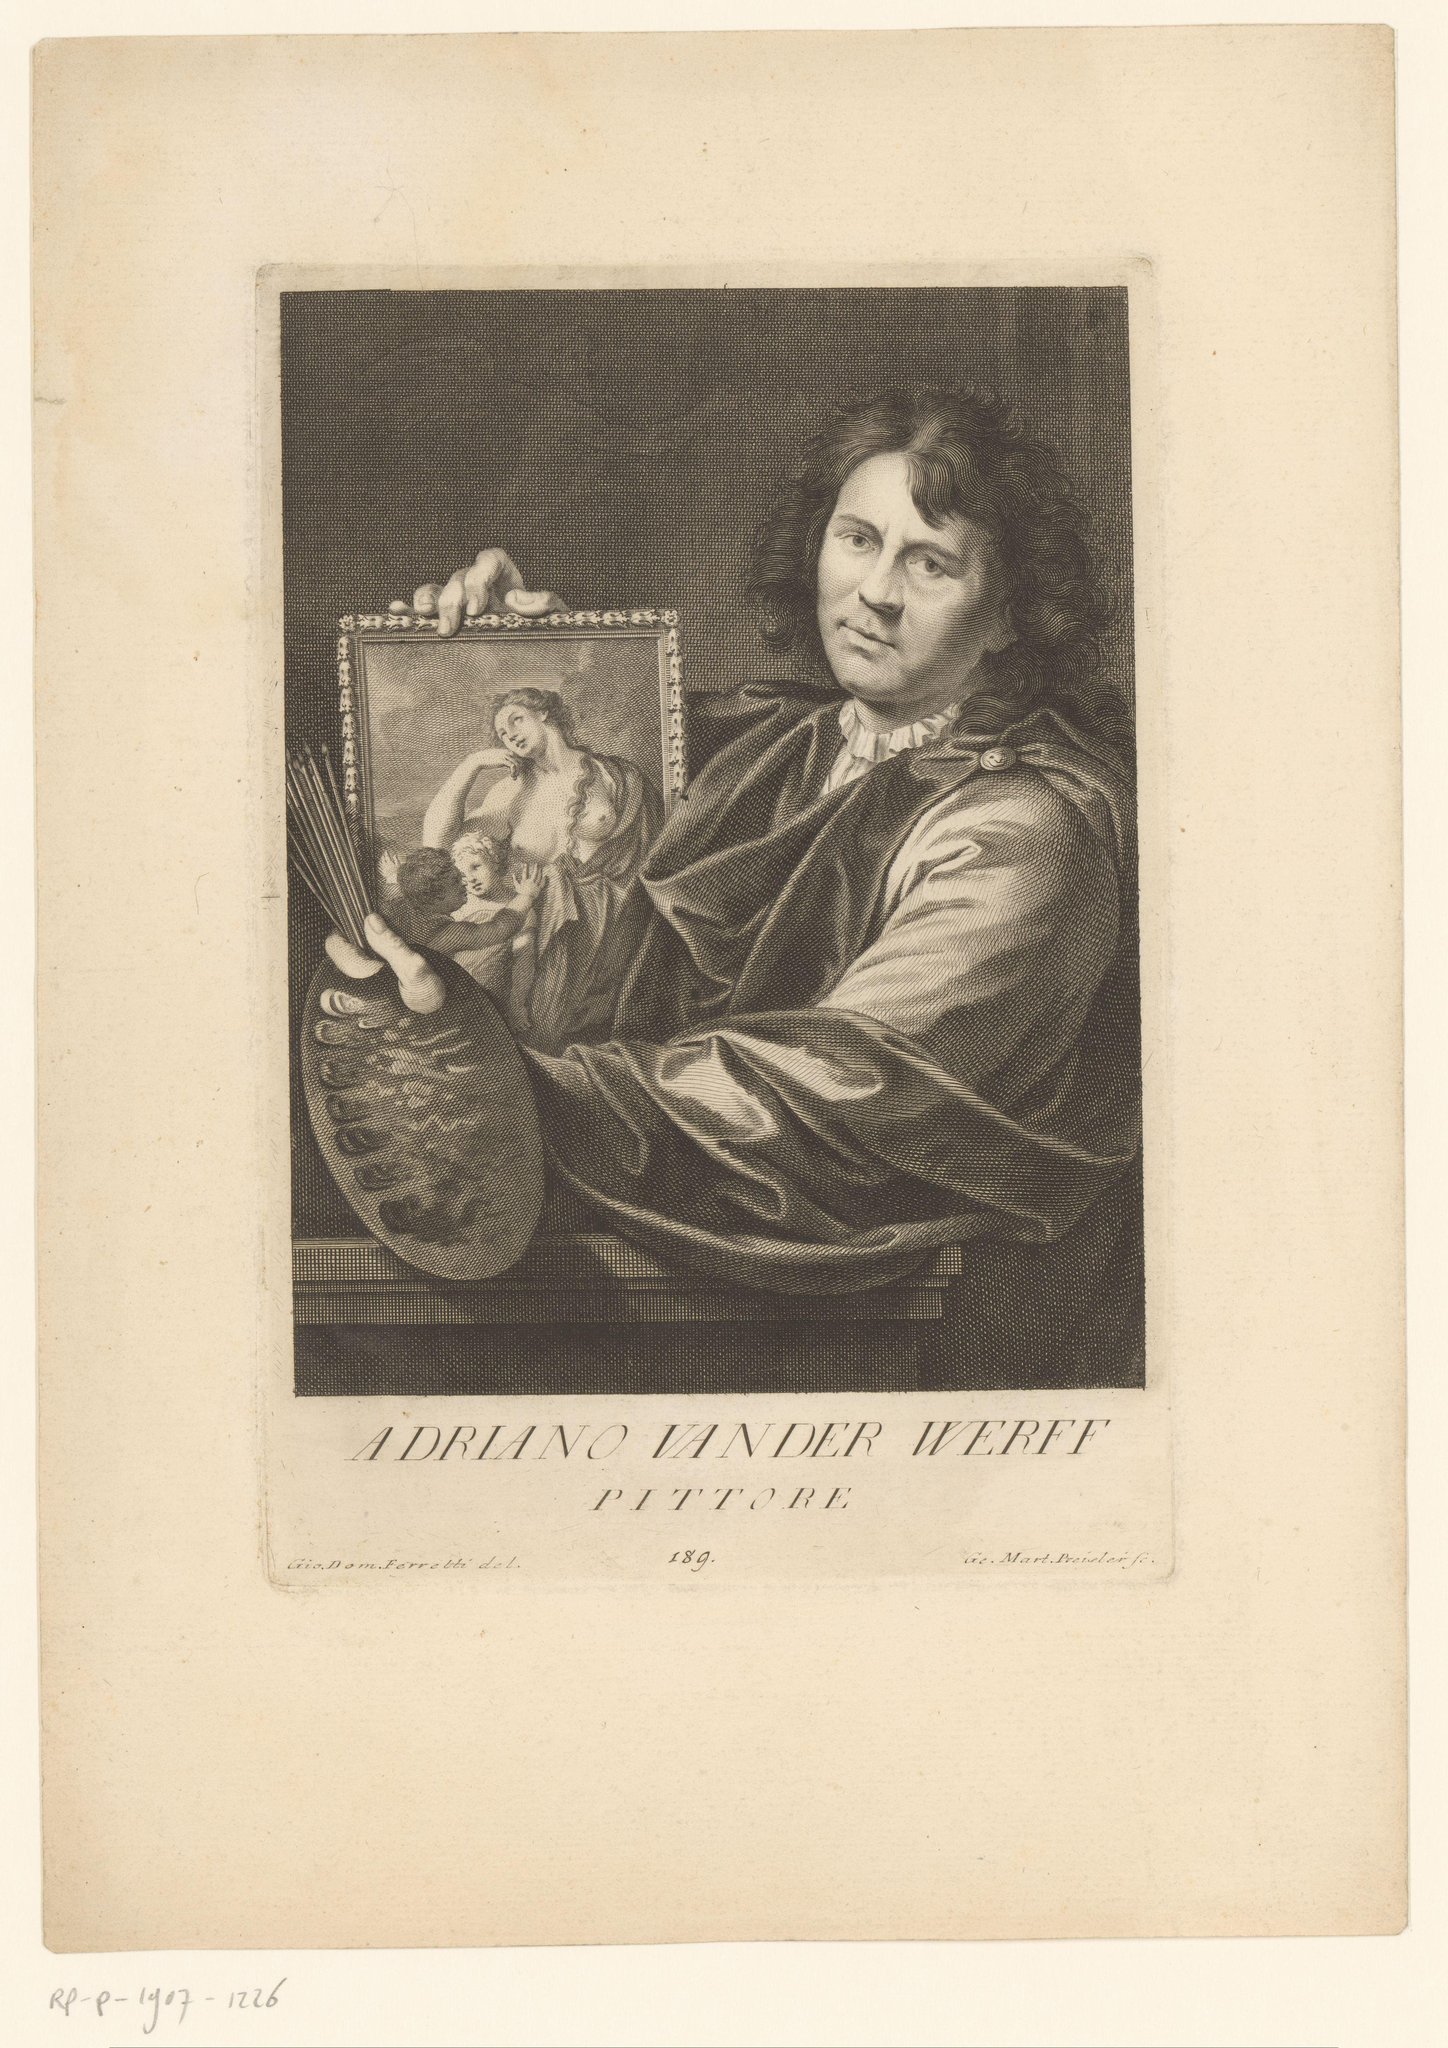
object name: print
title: Portret van Adriaen van der Werff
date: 1710-1754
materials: paper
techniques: engraving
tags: kralingen-ambacht, rotterdam, painter, print maker, adriaen van der werff, historical persons, portrait, self-portrait of artist, palette, picture, painting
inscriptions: collector's mark: Lugt 2228, number: ‘189.’